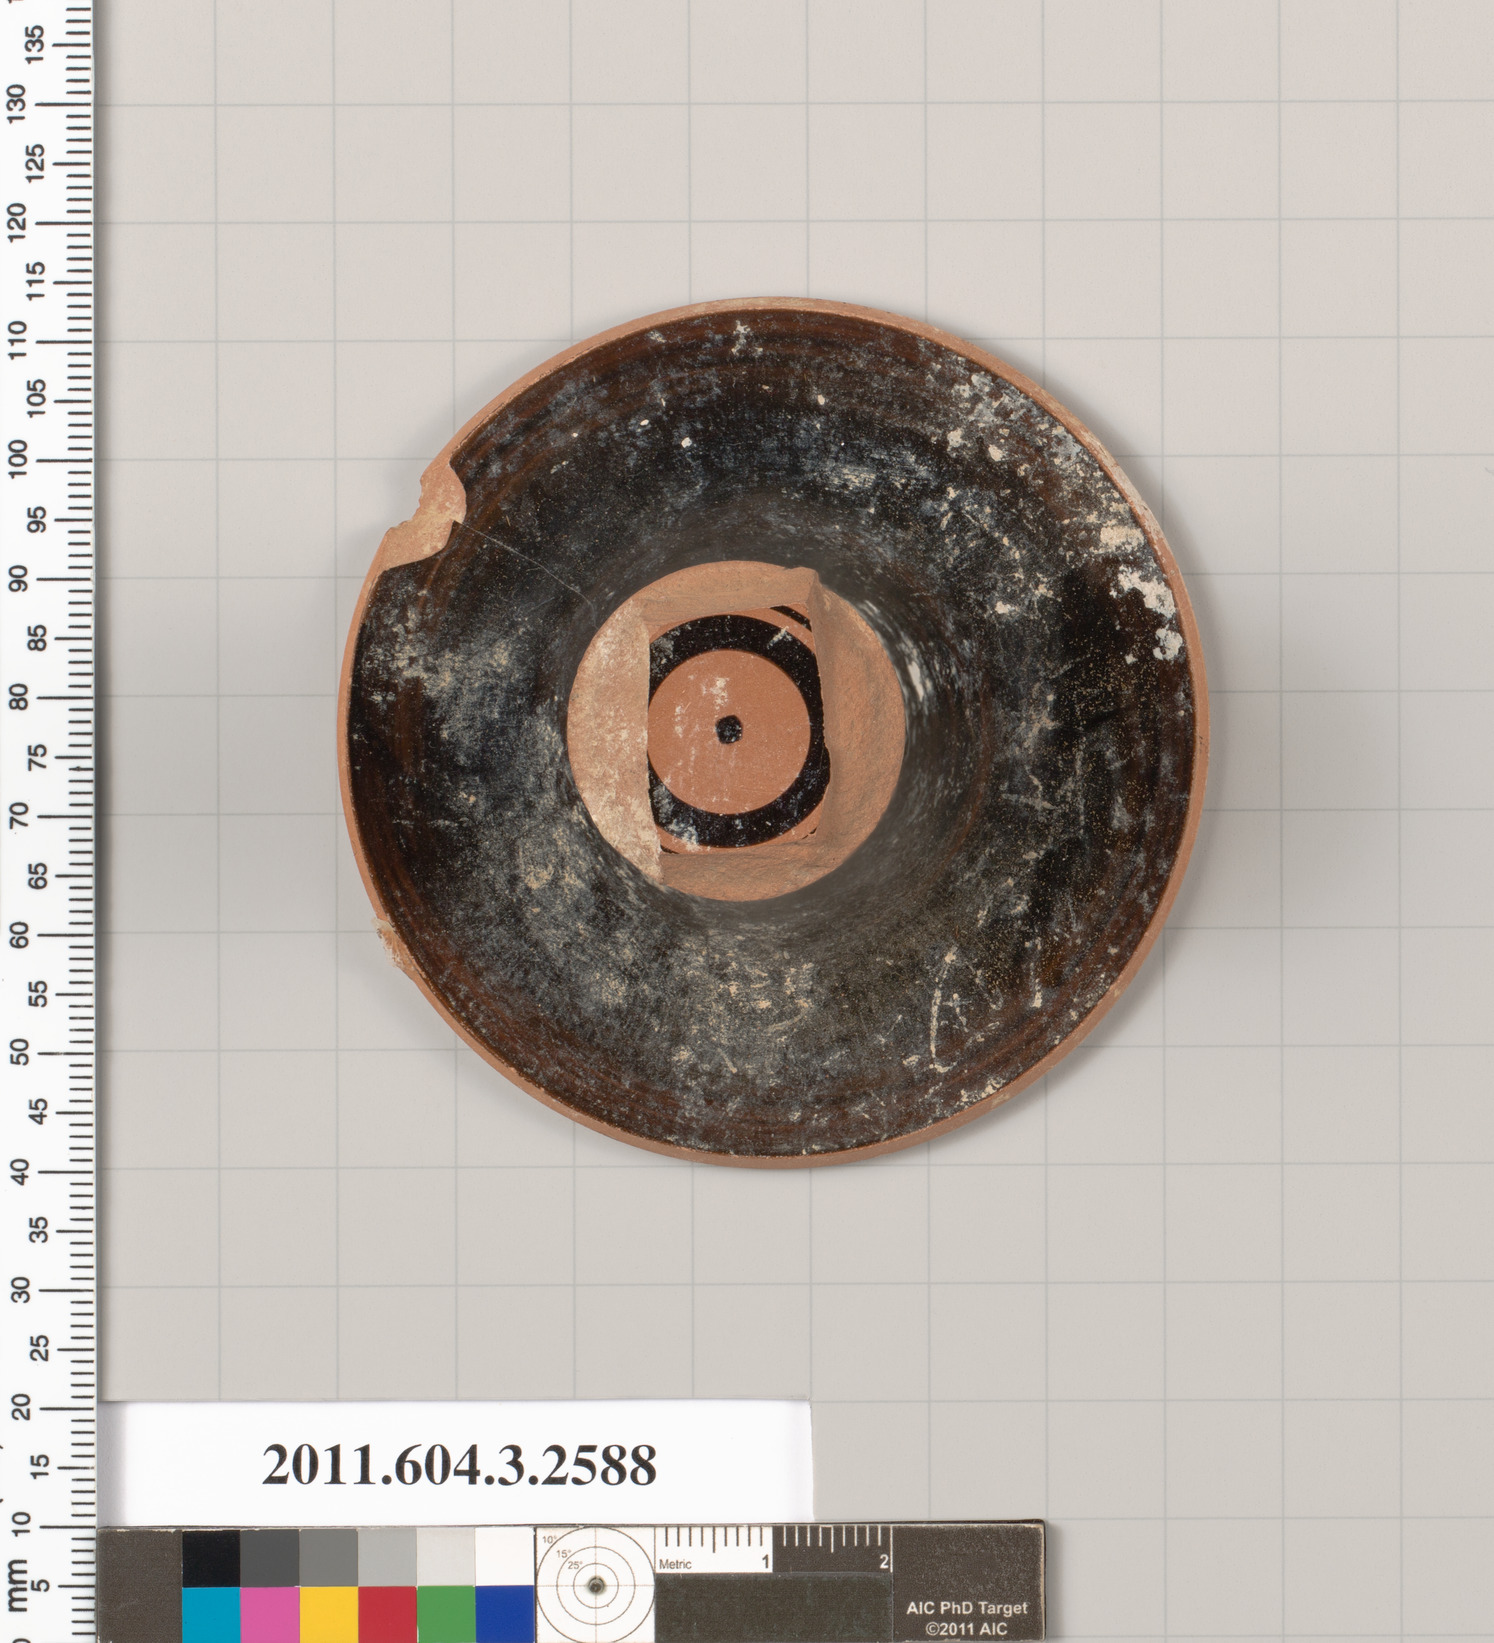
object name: kylix fragment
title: Terracotta fragment of a Little Master cup (drinking cup)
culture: greek, attic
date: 575-525 BCE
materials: terracotta